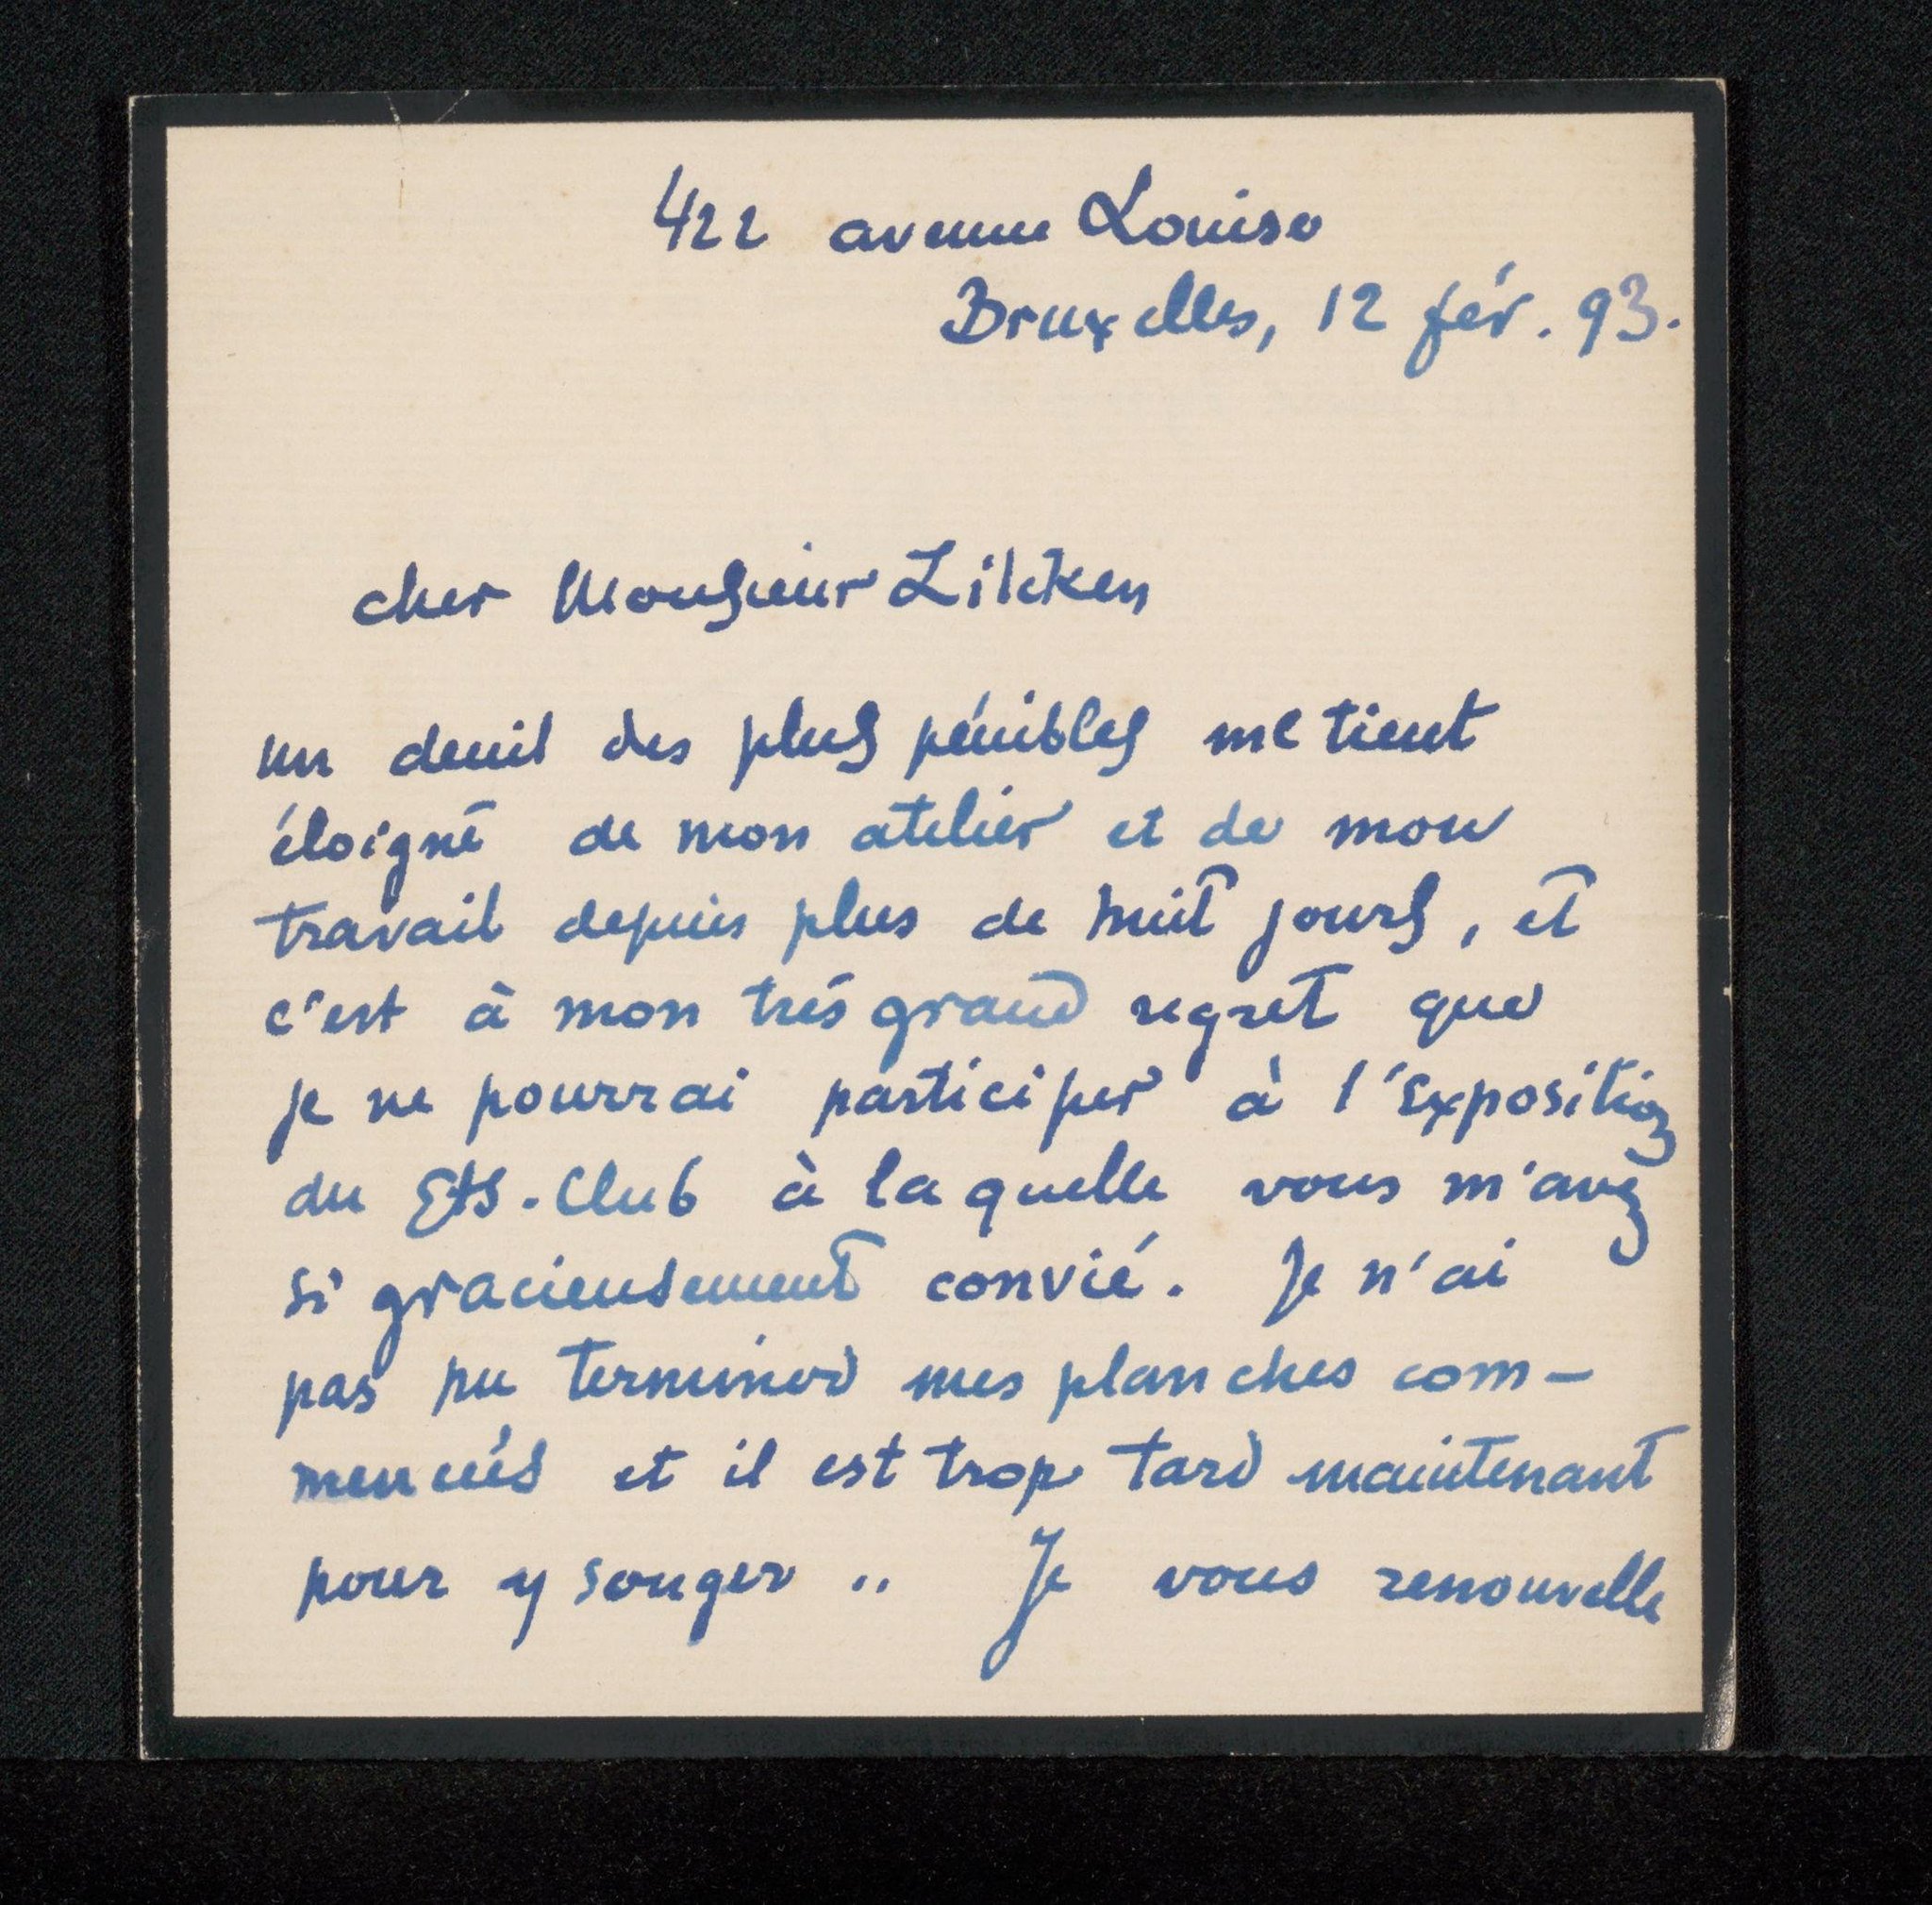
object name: letter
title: Brief aan Philip Zilcken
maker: theo van rysselberghe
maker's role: draughtsman, print maker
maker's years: 1862-1926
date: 1893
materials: ink, paper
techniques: pen, writing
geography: brussels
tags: the hague, painter, philip zilcken, the graphic arts, exhibition ~ art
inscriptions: collector's mark: ‘RPK’